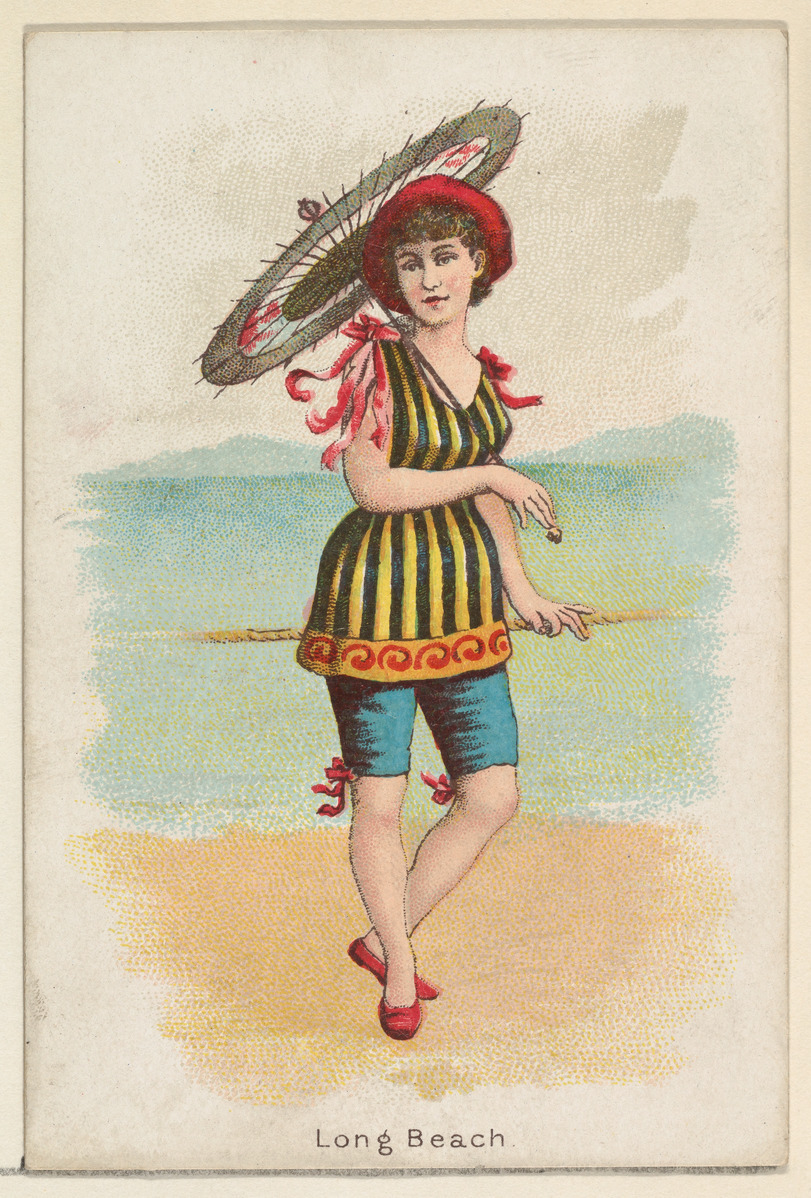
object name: print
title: Long Beach, from the Beautiful Bathers series (N192) issued by Wm. S. Kimball & Co.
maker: william s. kimball & company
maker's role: publisher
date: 1889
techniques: color lithograph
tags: women